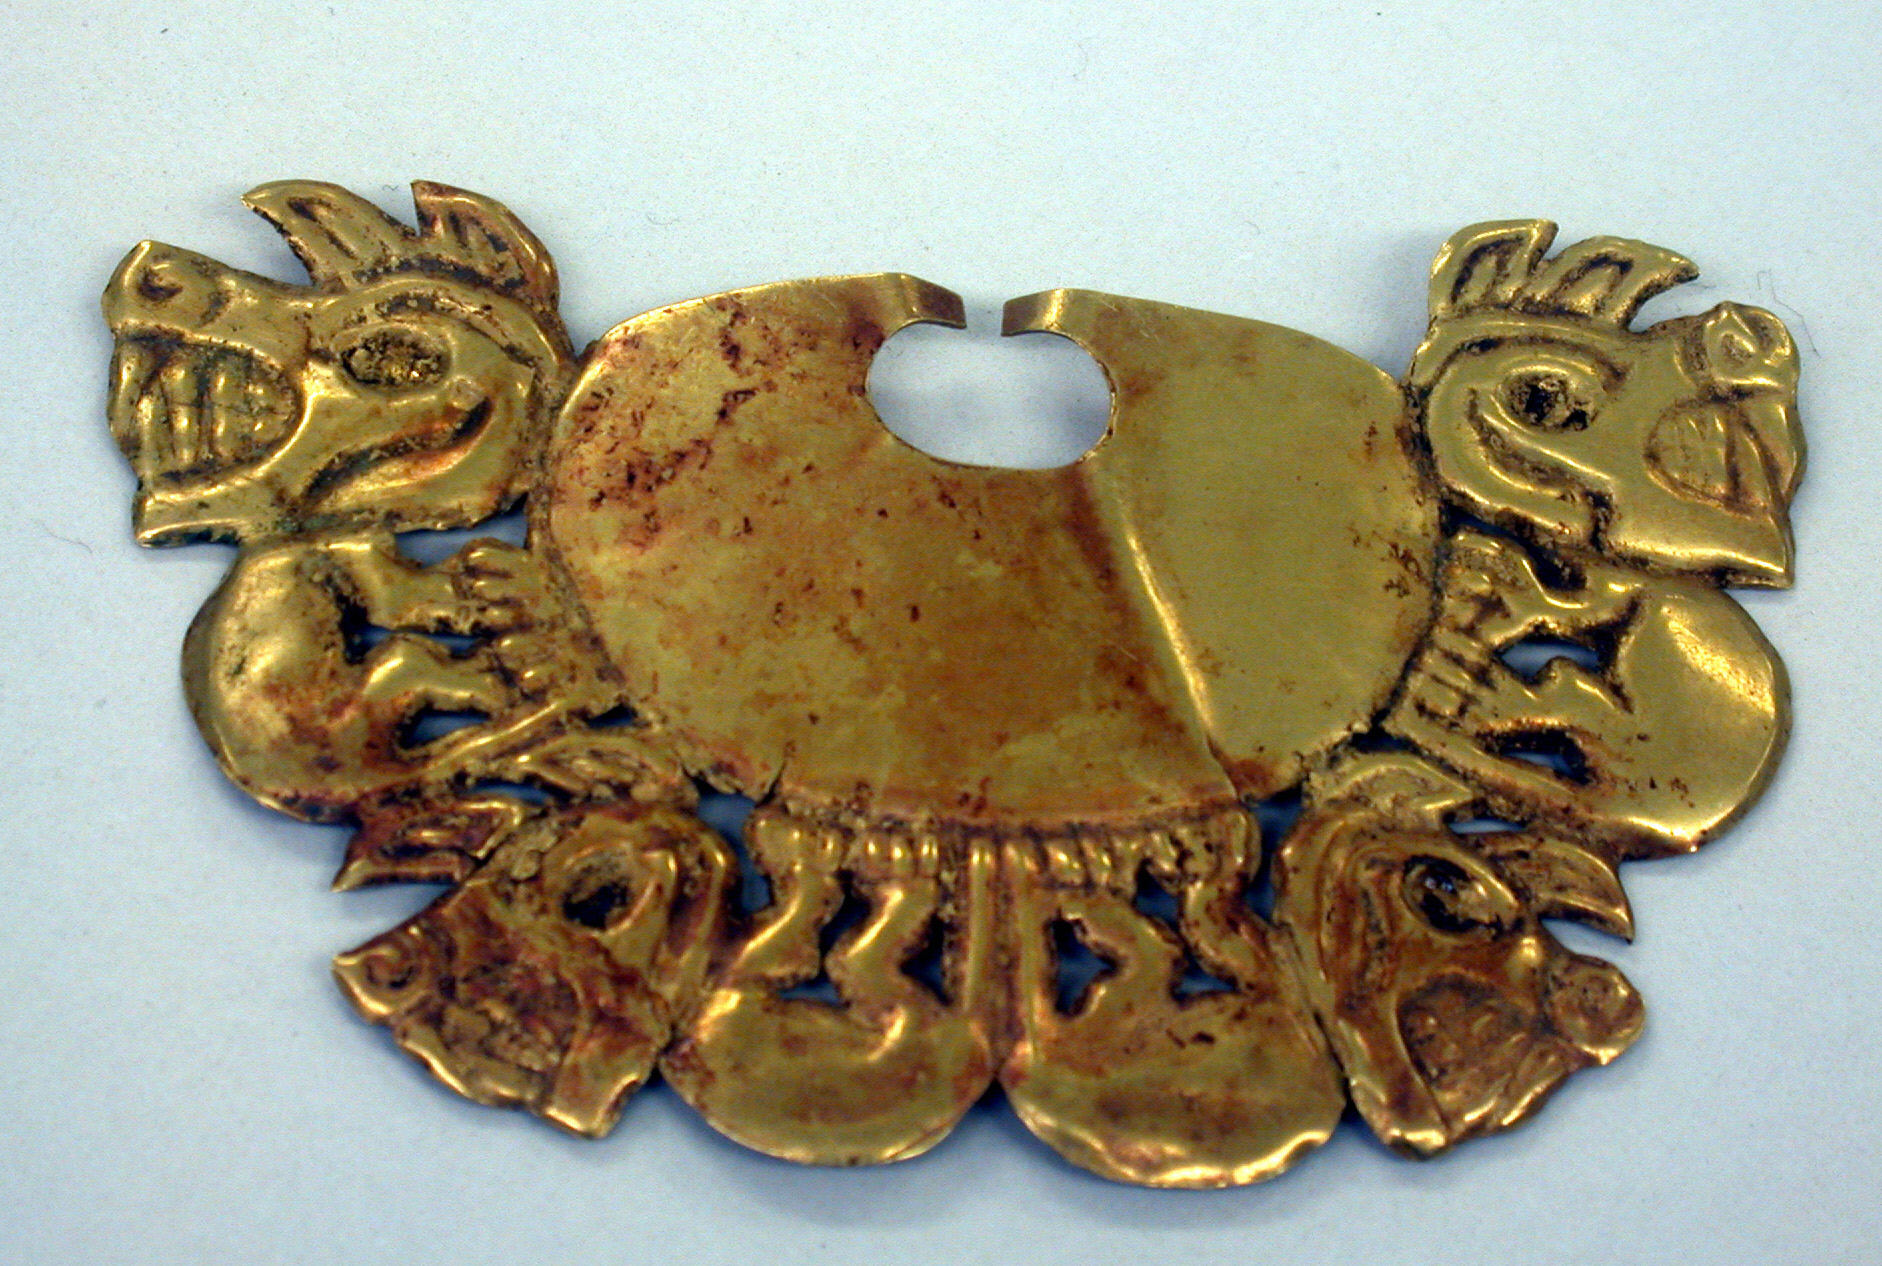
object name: nose ornament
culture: moche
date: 501-700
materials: gold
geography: peru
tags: animals